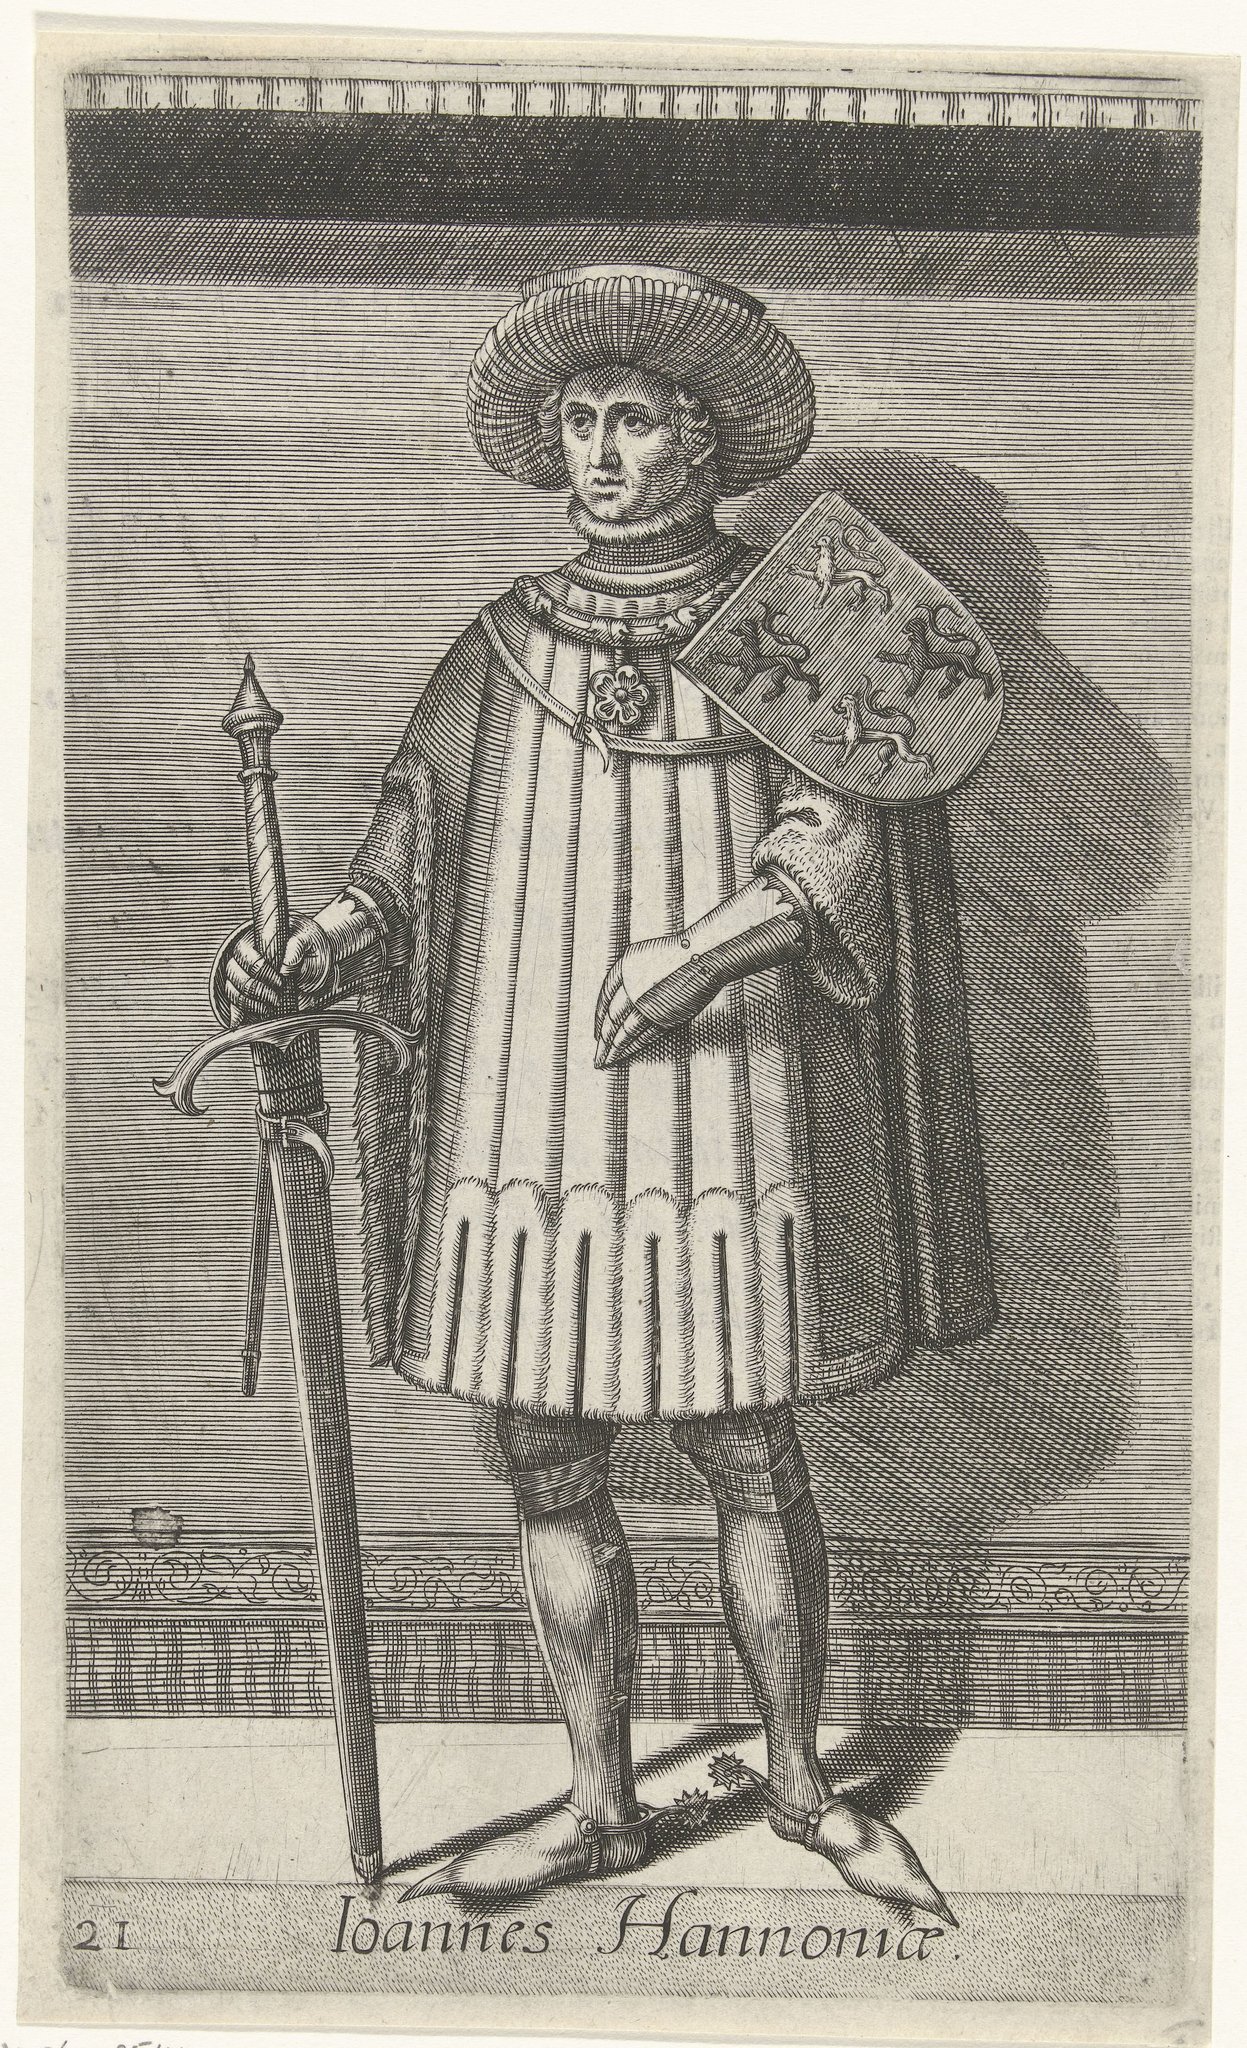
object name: book illustration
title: Portret van Jan II, graaf van Holland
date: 1578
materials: paper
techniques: engraving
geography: antwerp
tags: jan ii (graaf van holland)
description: Jan II, graaf van Holland en Henegouwen. Staande, ten voeten uit. Hij draagt een zwaard in zijn rechterhand. Op zijn linkerschouder het wapenschild van Holland en Henegouwen. De prent dient als een illustratie bij een boek over de geschiedenis van de graven van Holland.